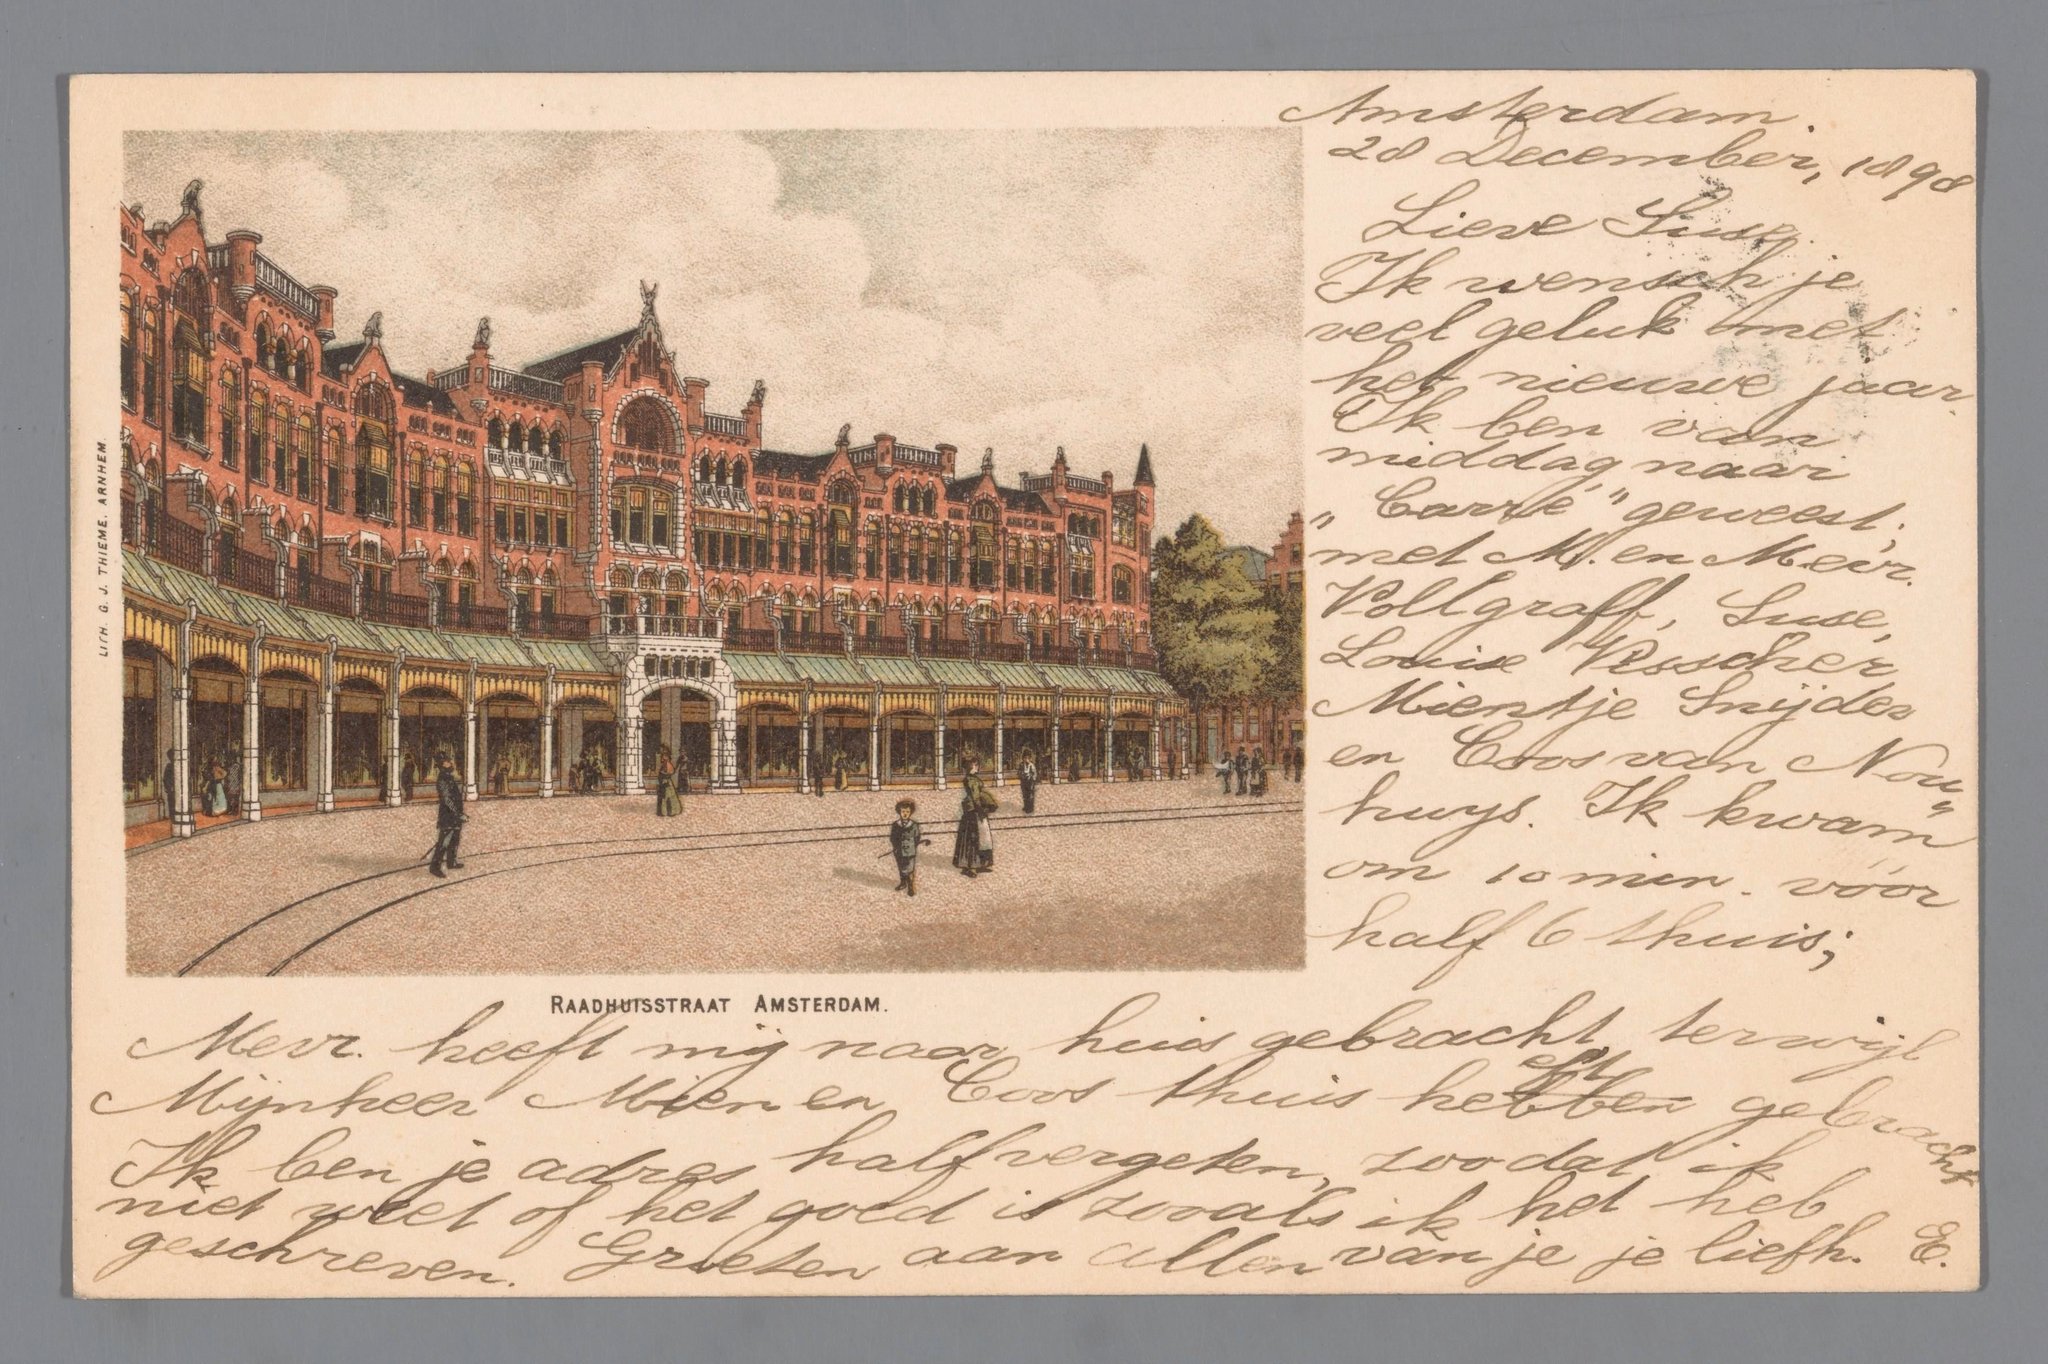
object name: photograph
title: Raadhuisstraat Amsterdam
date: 1898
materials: cardboard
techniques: writing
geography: amsterdam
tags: front façade